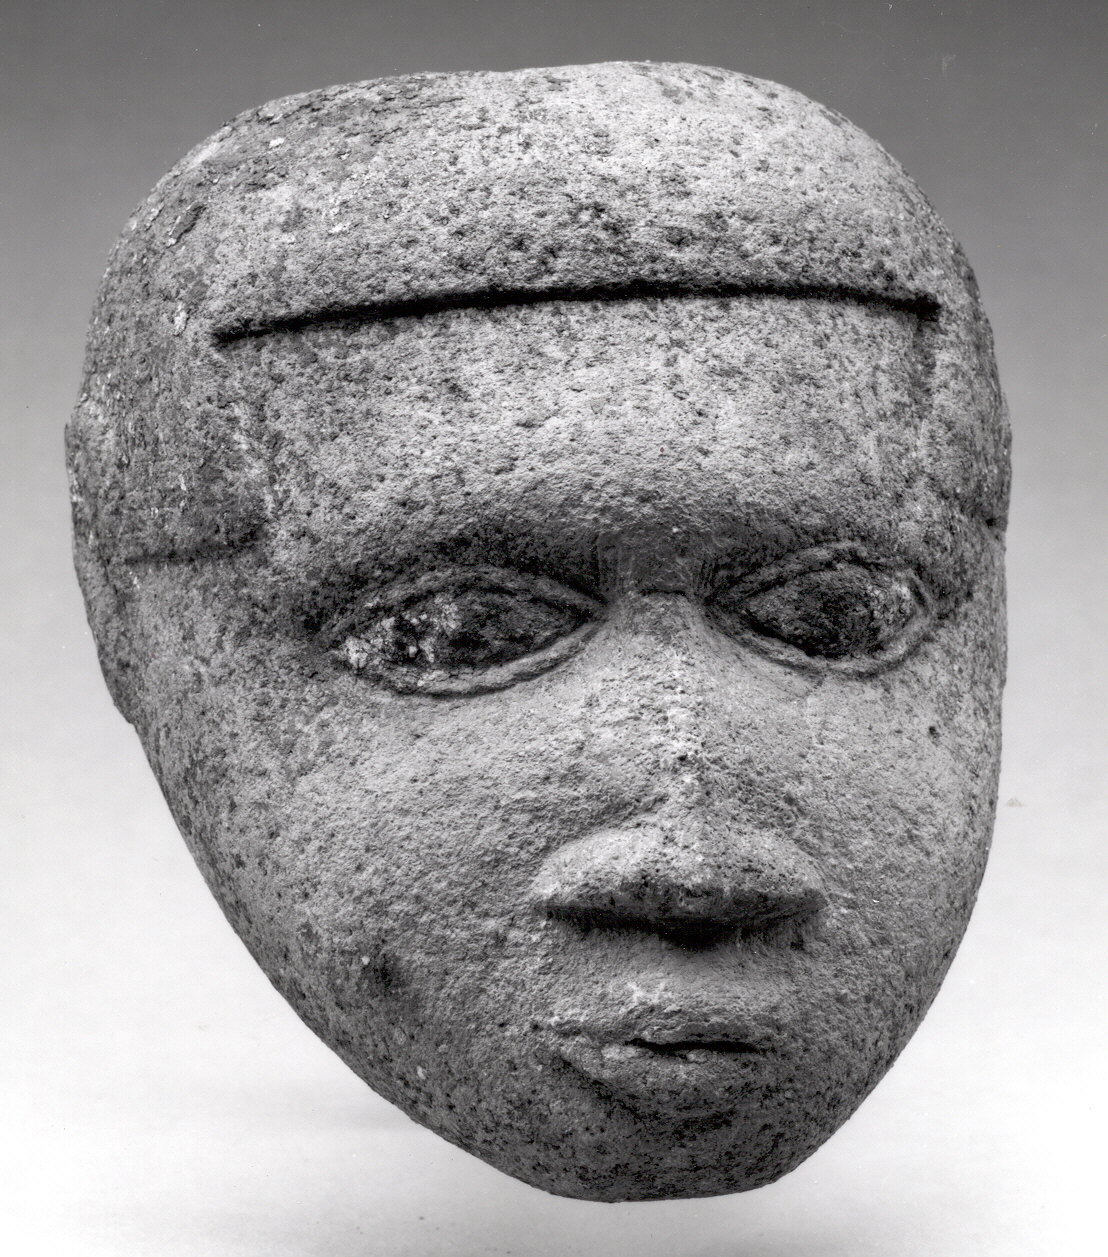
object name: head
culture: edo period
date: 1501-1800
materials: pigment, terracotta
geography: nigeria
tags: heads